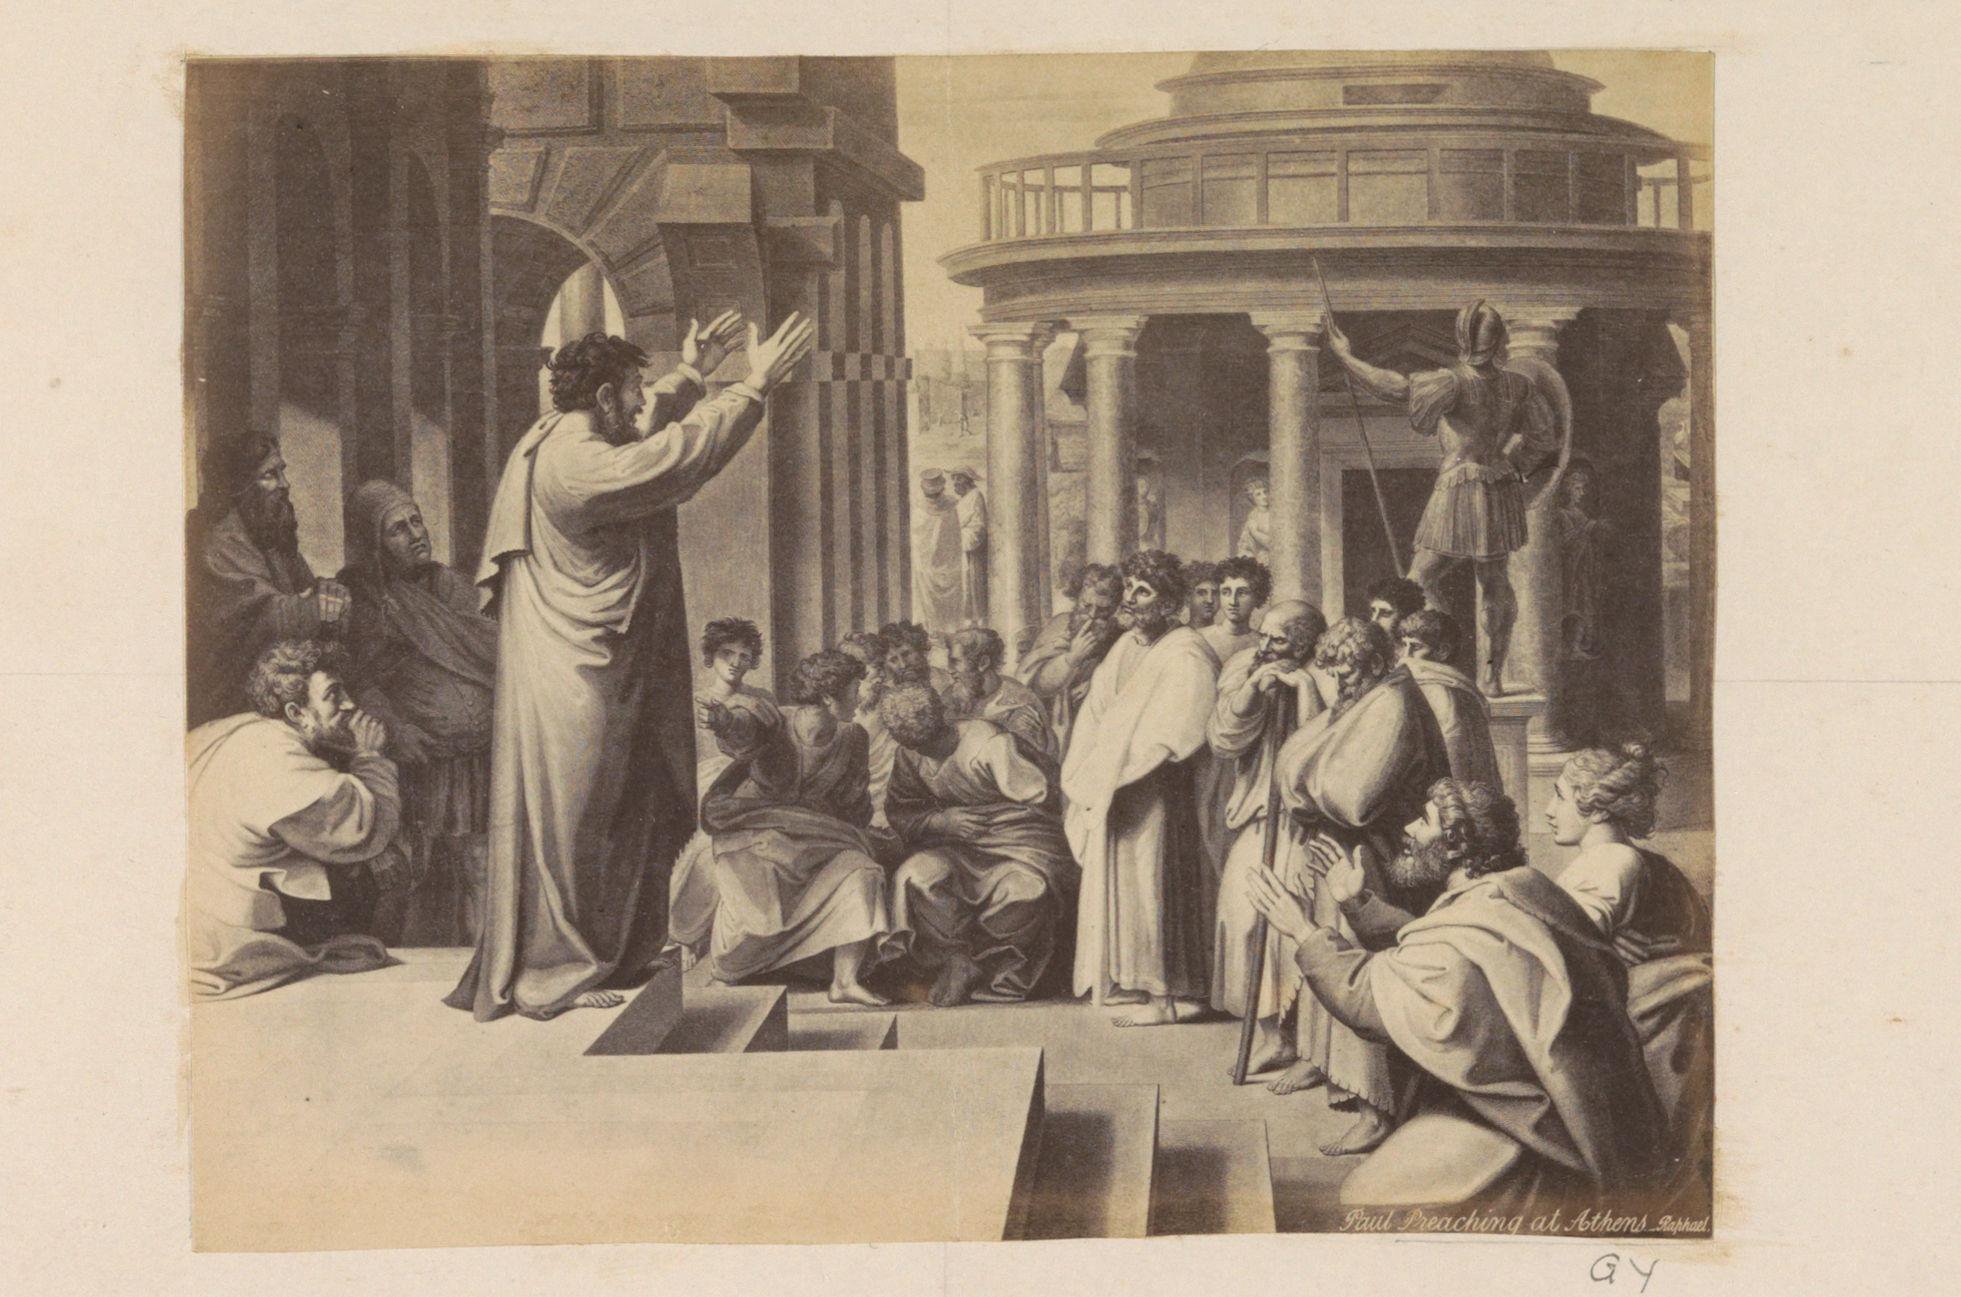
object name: reproduction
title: Fotoreproductie van (vermoedelijk) een prent naar een ontwerpschets van Rafaël voor een tapijt in de Sixtijnse Kapel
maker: Anonymous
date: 1850-1870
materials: paper, photographic support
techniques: albumen print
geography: england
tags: paul in athens: on the areopagus he discusses with philosophers (in front of the temple of mars)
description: Onderdeel van Album met foto's van bezienswaardigheden en landschappen in Engeland en van kunst.